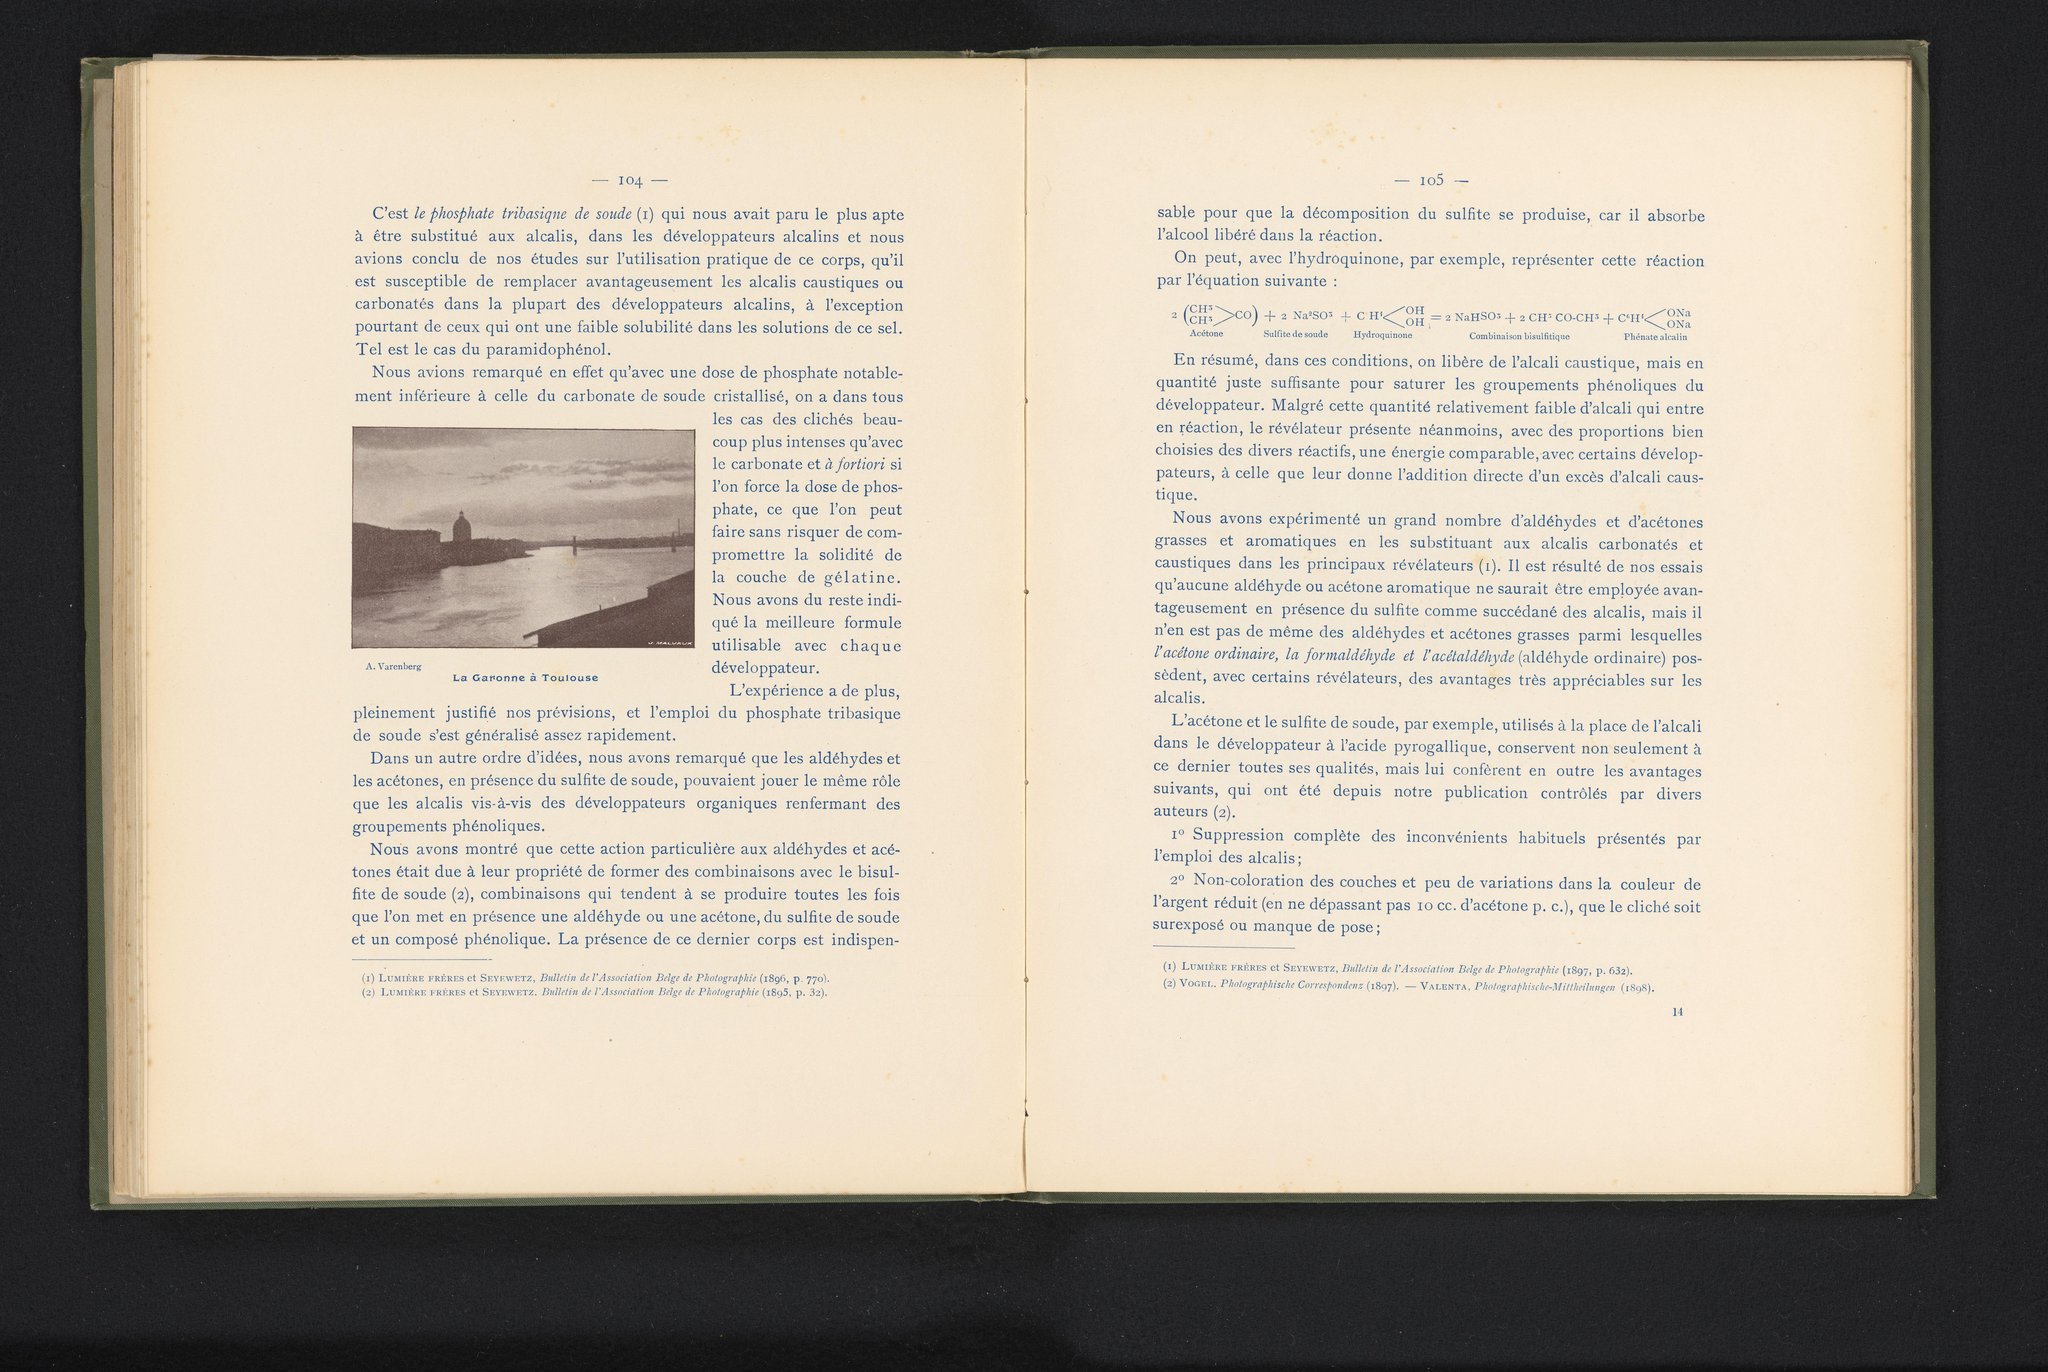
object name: page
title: La Garonne á Toulouse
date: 1893-1898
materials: paper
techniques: autotype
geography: toulouse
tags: river